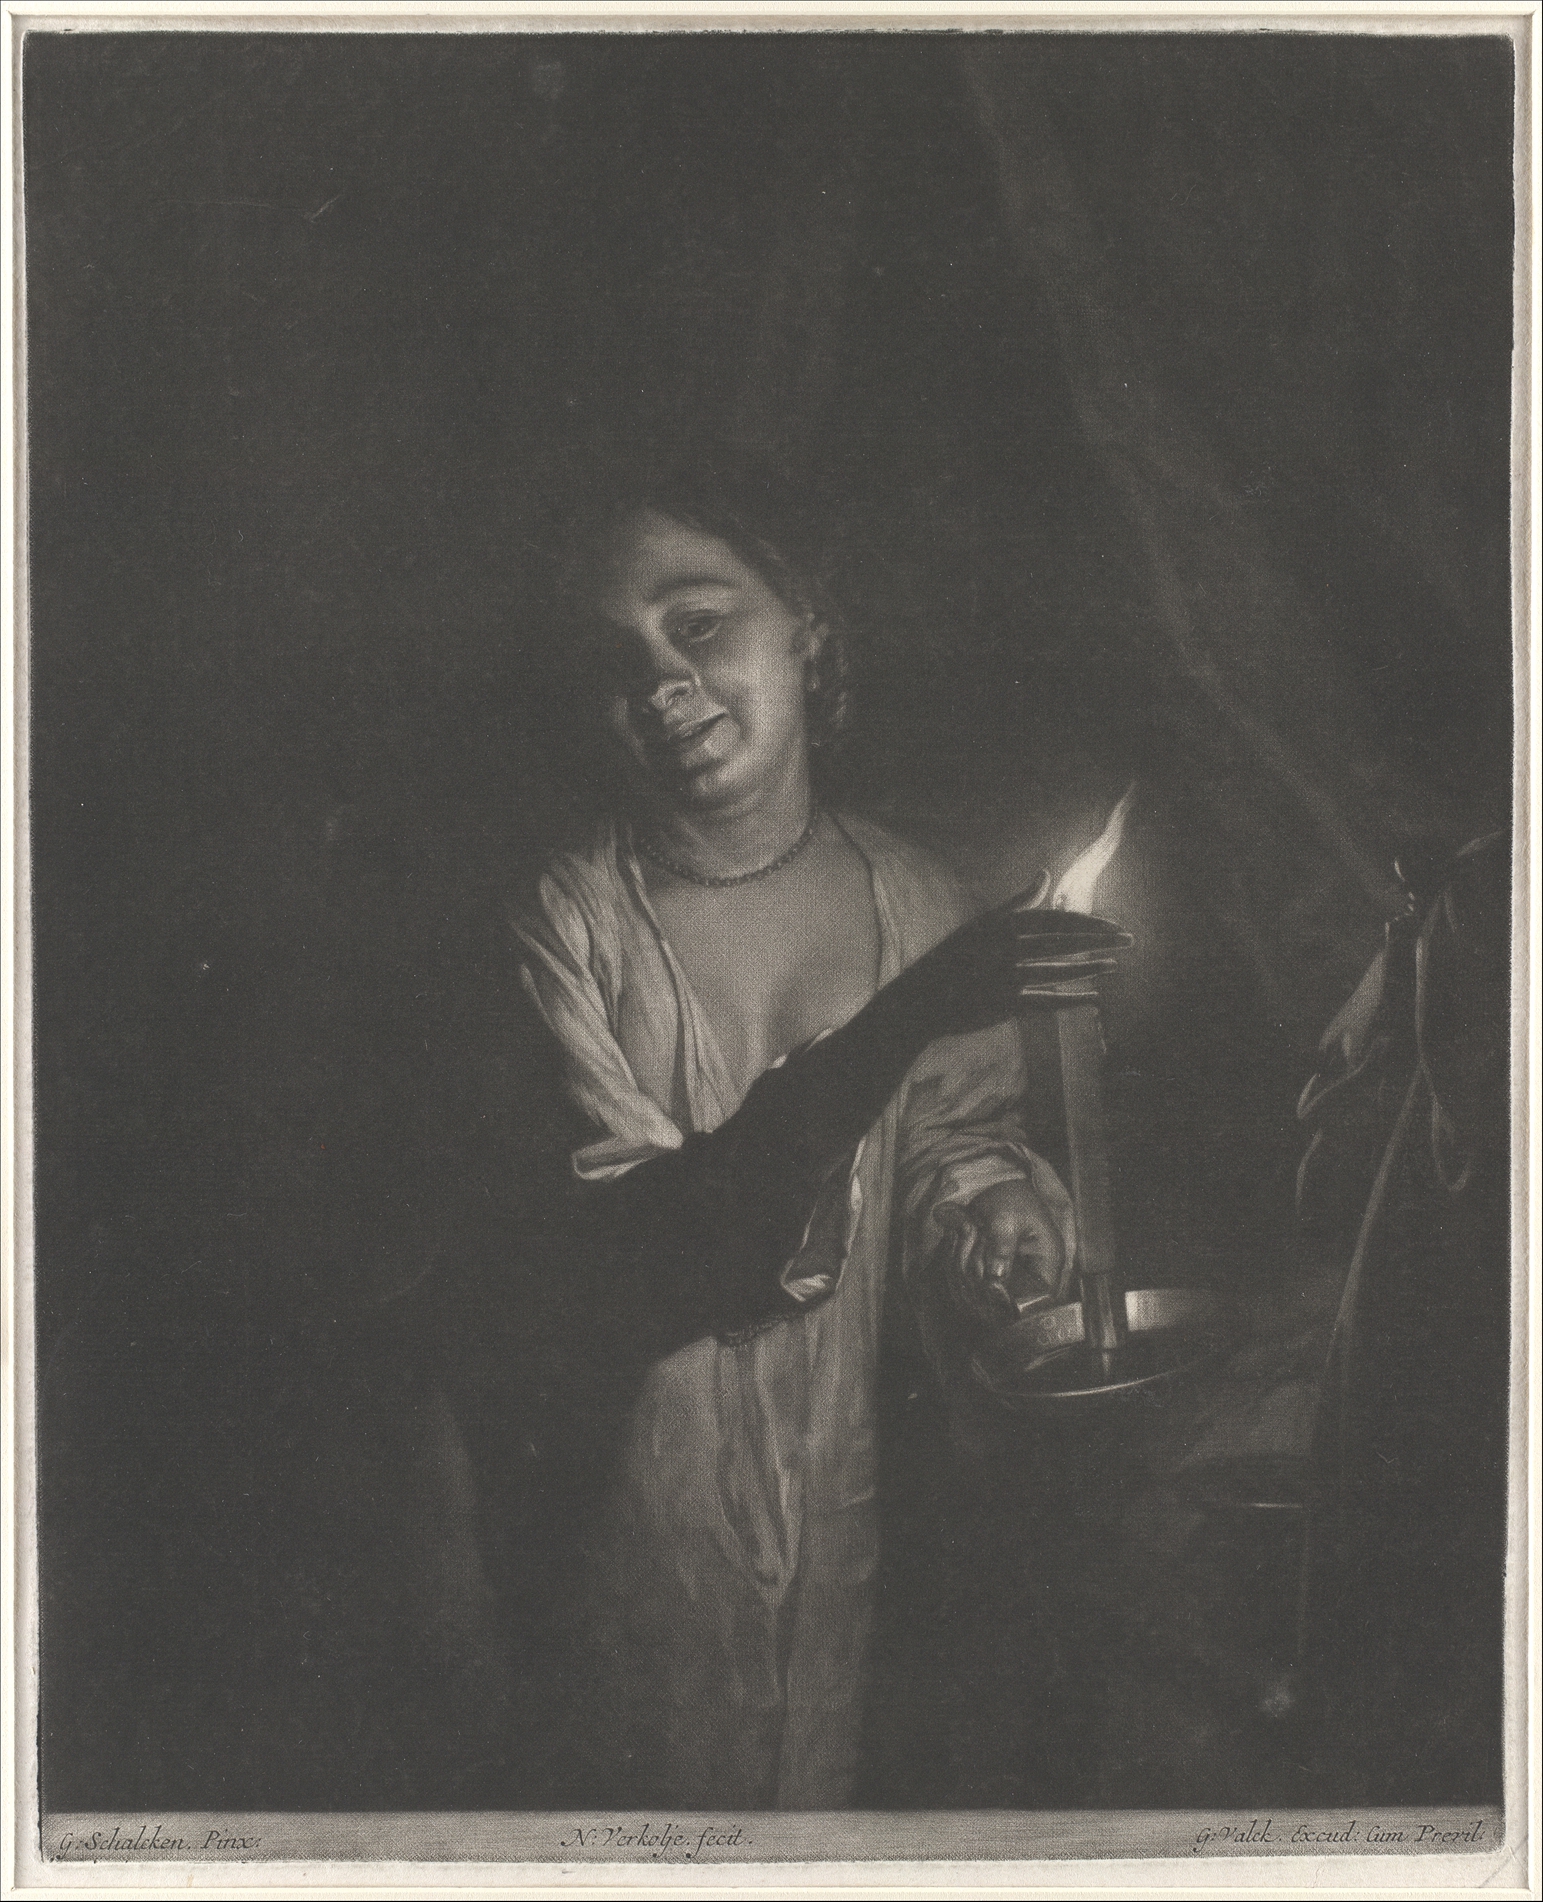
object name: print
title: Young Woman Holding a Candle in a Bedchamber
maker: nicholas verkolje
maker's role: artist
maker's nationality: dutch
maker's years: 1673-1746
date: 1690-1715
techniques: mezzotint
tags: women,candles